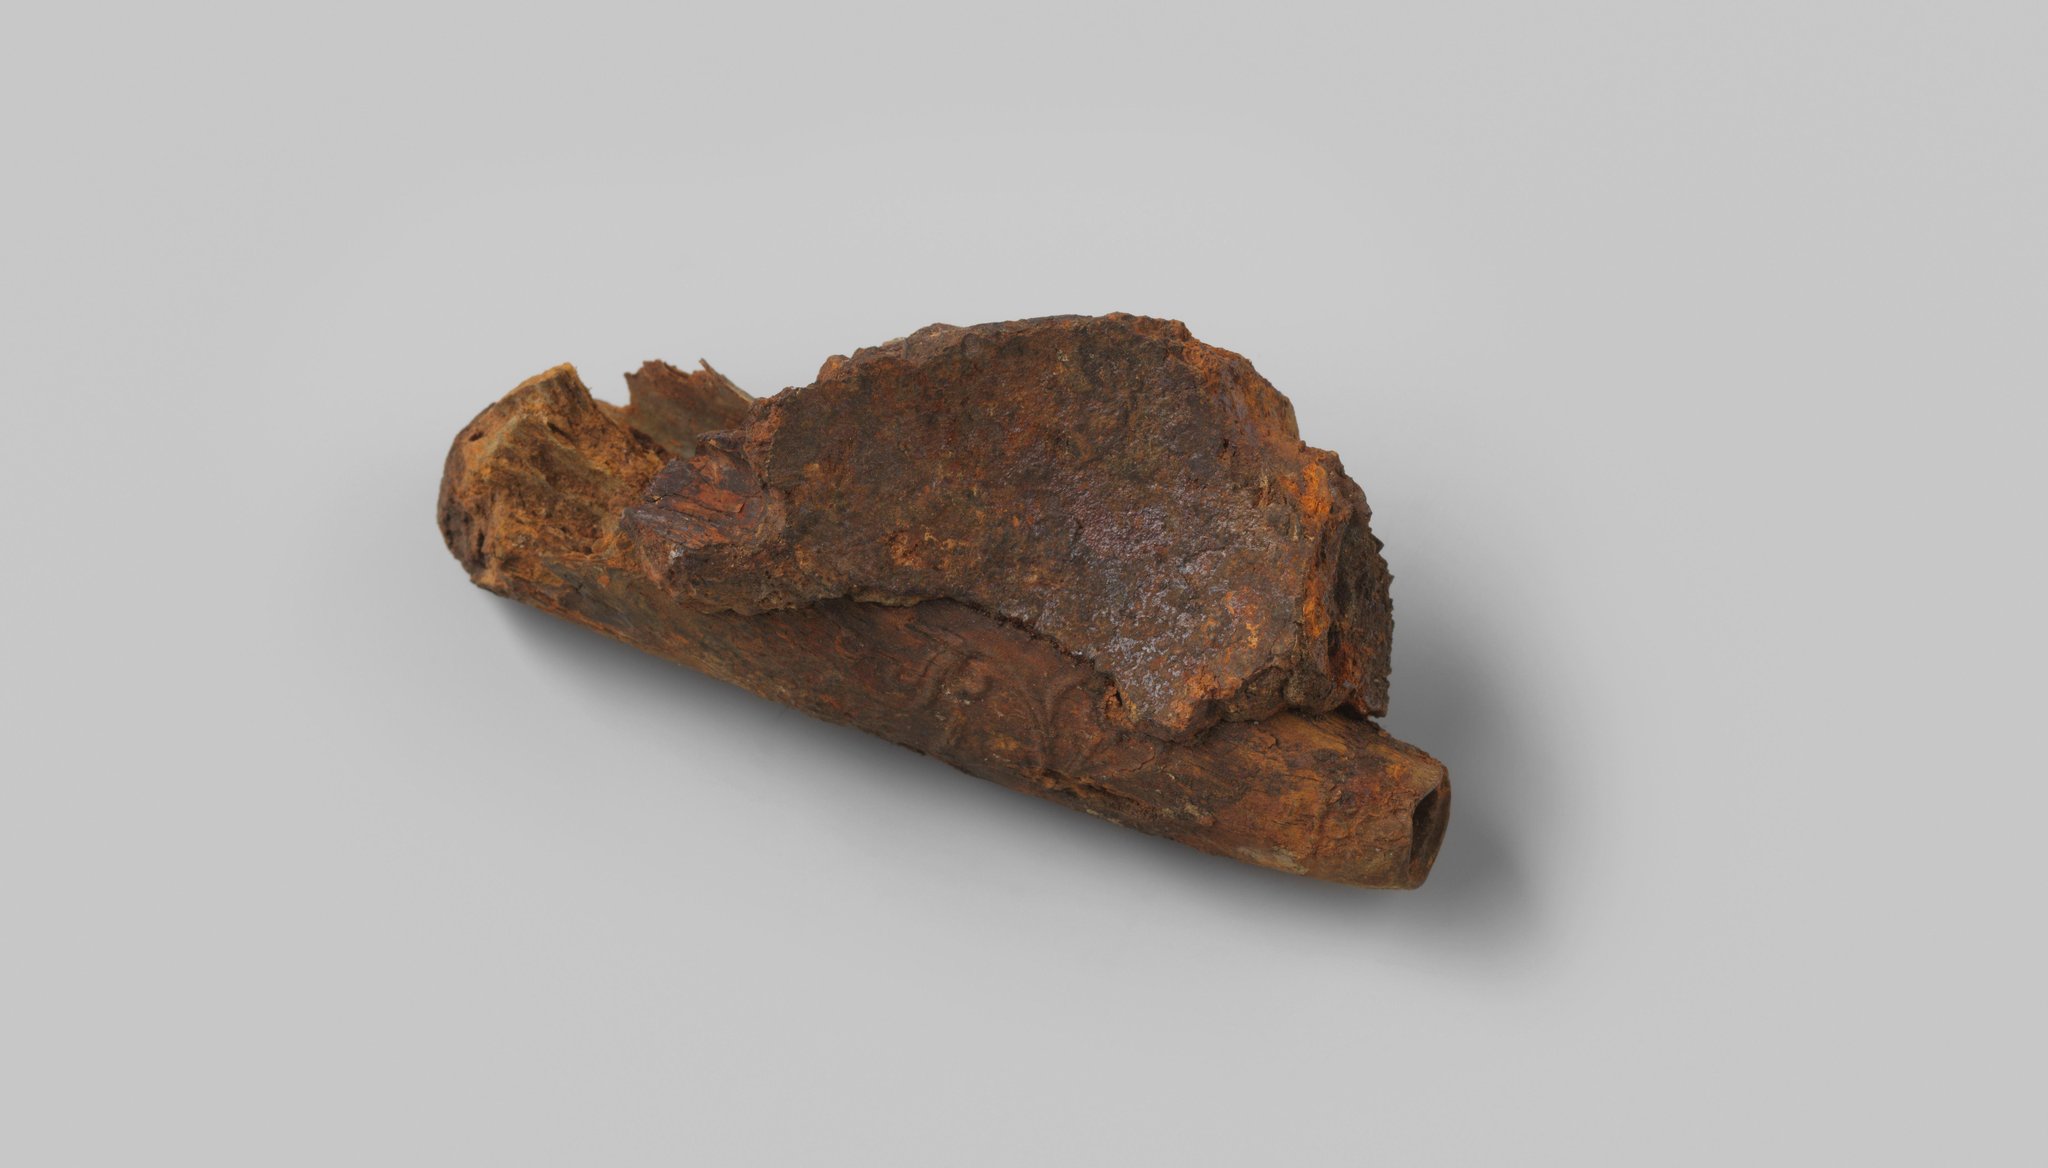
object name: knife handle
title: Messenheft met concretie uit het wrak van de Oost-Indiëvaarder Meresteijn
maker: Anonymous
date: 1693-1702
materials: stone, copper, wood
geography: netherlands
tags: cape of good hope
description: Houten messenheft met koperen ring met aangroeisels. In het hout en het aangroeisel staan de afdrukken van vrij grote munten waarmee het mesheft kennelijk op de wrakplaats heeft liggen wachten om gevonden te worden. Knife-handle.